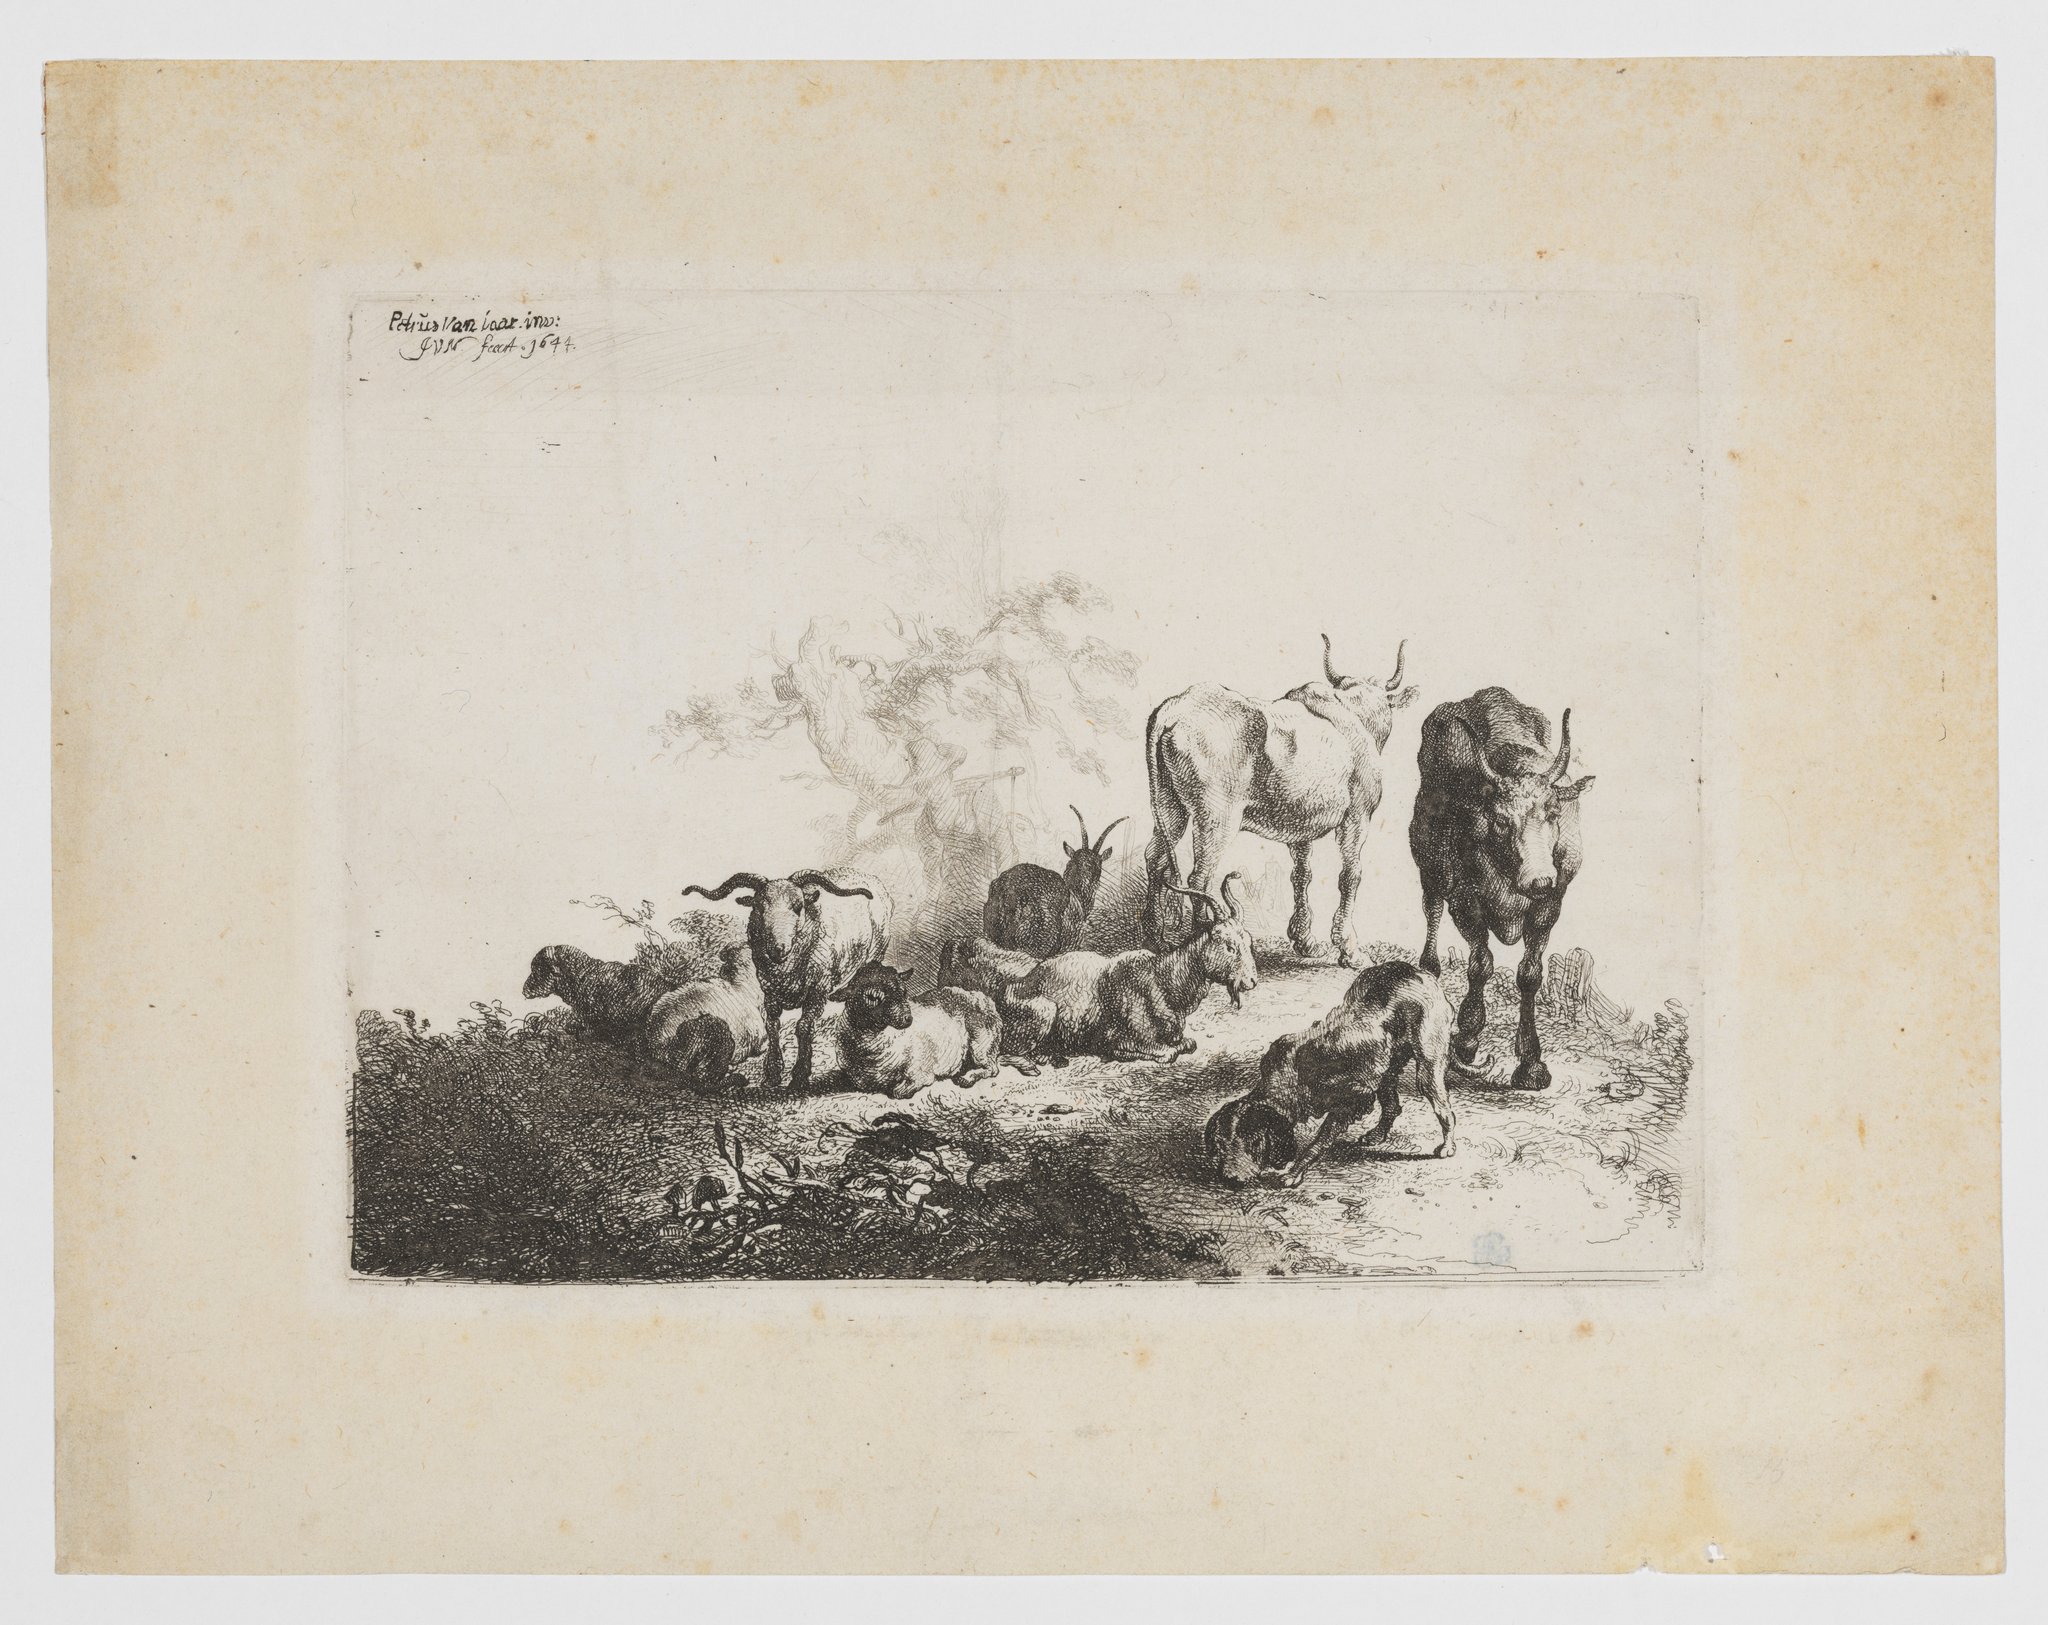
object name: print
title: Landscape with Cattle and a Milkmaid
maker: jan van noordt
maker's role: artist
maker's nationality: dutch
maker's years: 1623-1681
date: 1644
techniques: drypoint, etching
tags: cows,dogs,goats